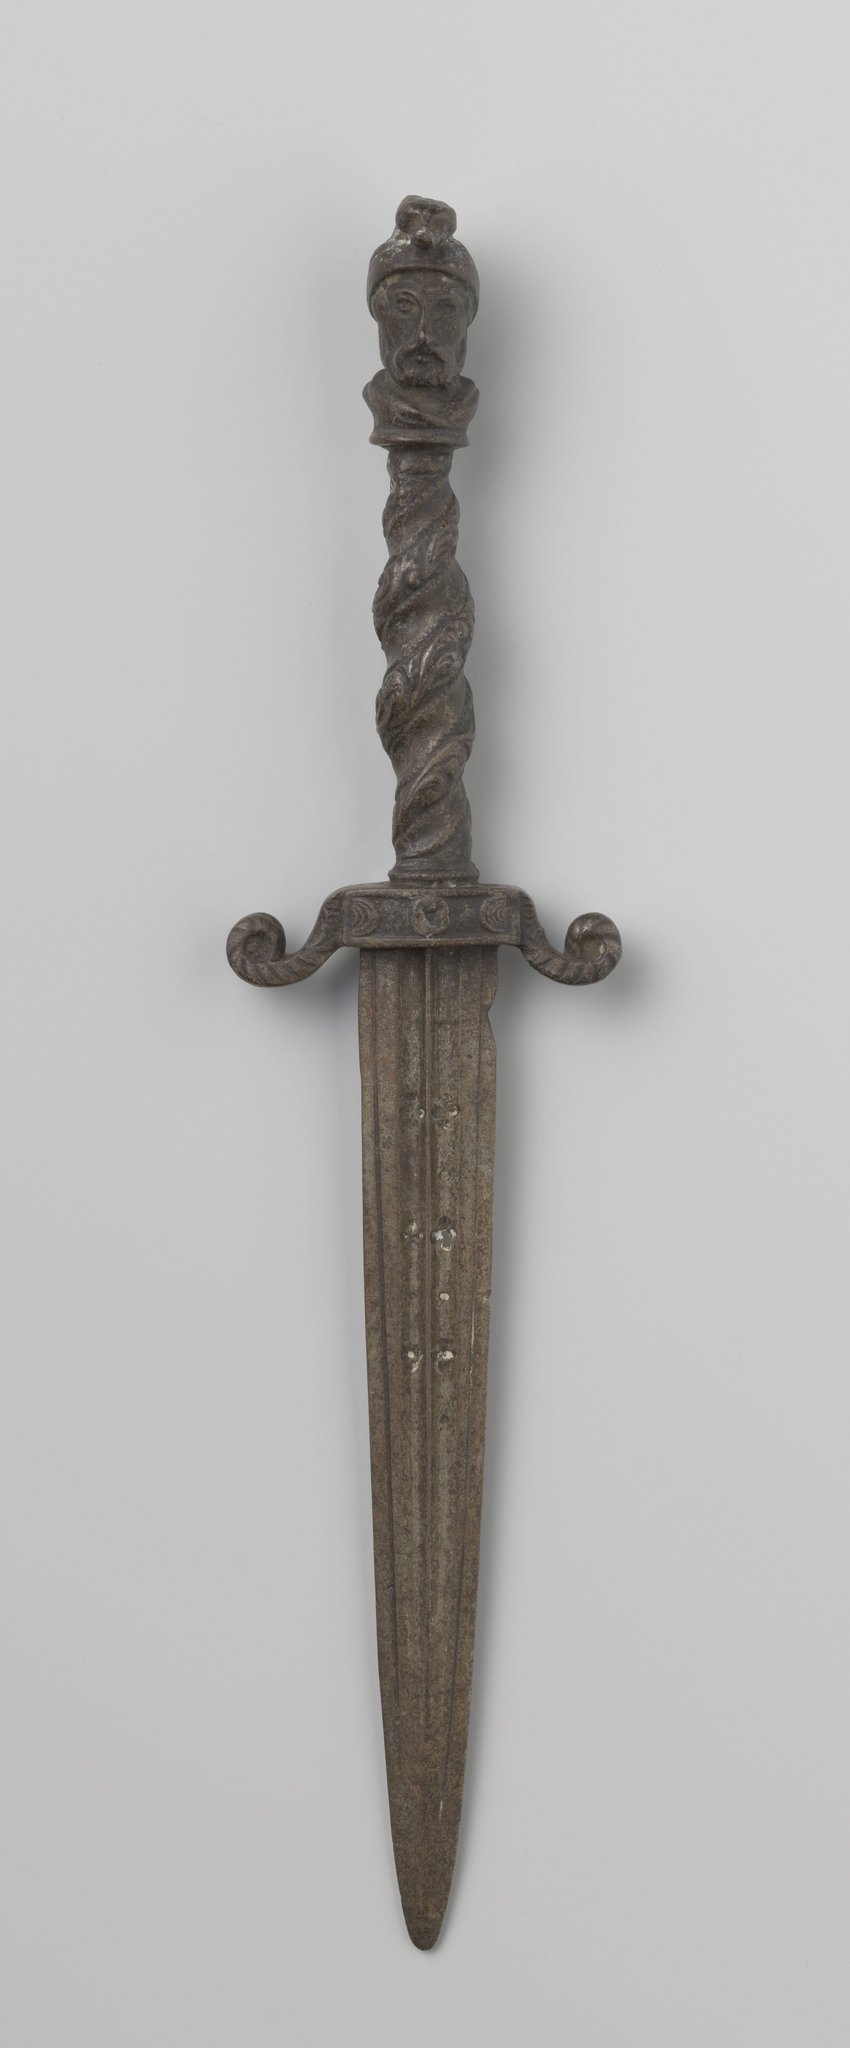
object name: dagger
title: Jachtdolk met mannenhoofd.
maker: Anonymous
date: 1499-1899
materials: iron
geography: europe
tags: europe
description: IJzeren dolk, taps toelopend, kling met een dubbele bloedgeul. De kop van de greep heeft de vorm van een bebaard mannenhoofd, met een bevervel als hoofddeksel. De pareerstang is aan beide zijden neerwaarts gekruld met in het midden een rosette. De greep van de dolk is versierd met spiraalgewijze floramotieven.